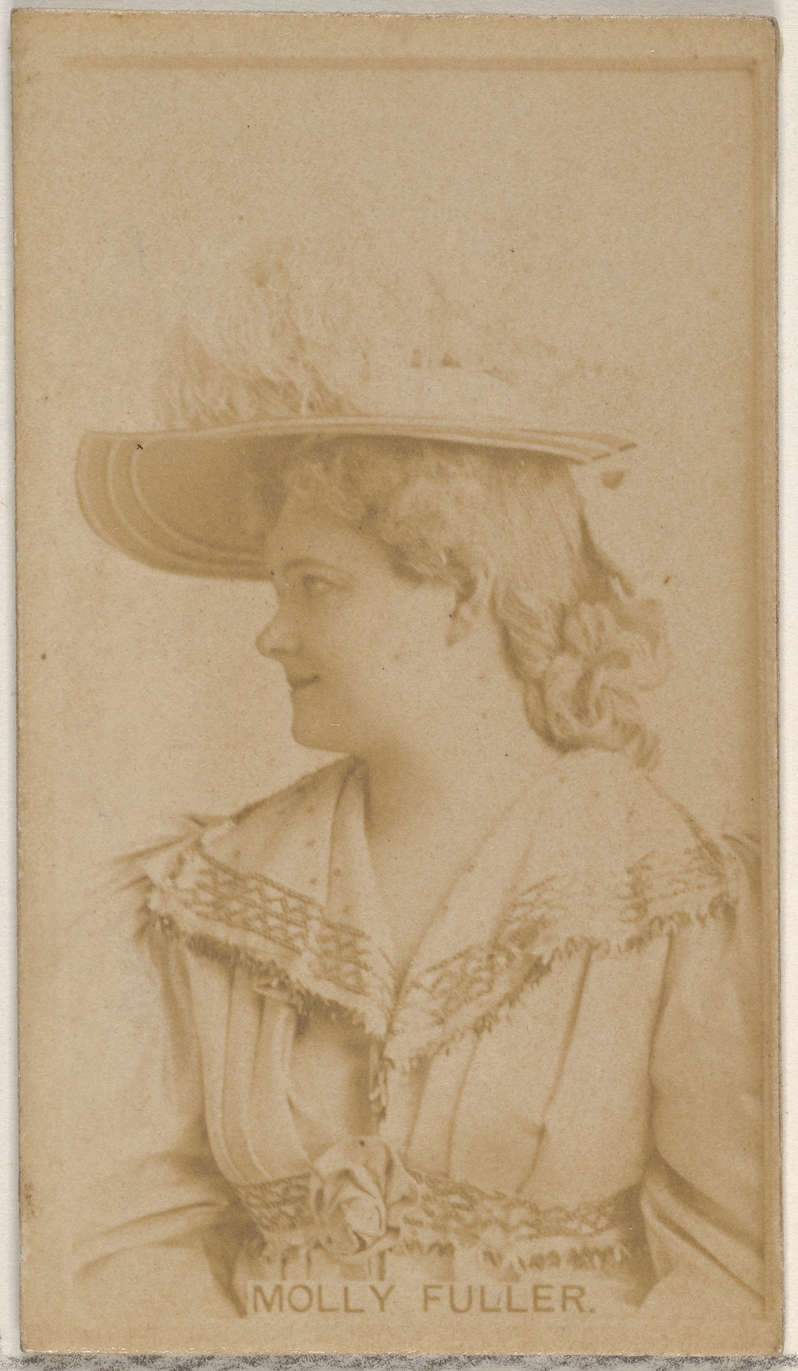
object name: photograph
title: Molly Fuller, from the Actors and Actresses series (N45, Type 8) for Virginia Brights Cigarettes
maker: allen & ginter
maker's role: publisher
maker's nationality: american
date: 1888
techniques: albumen silver print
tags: portraits,profiles,women,actresses